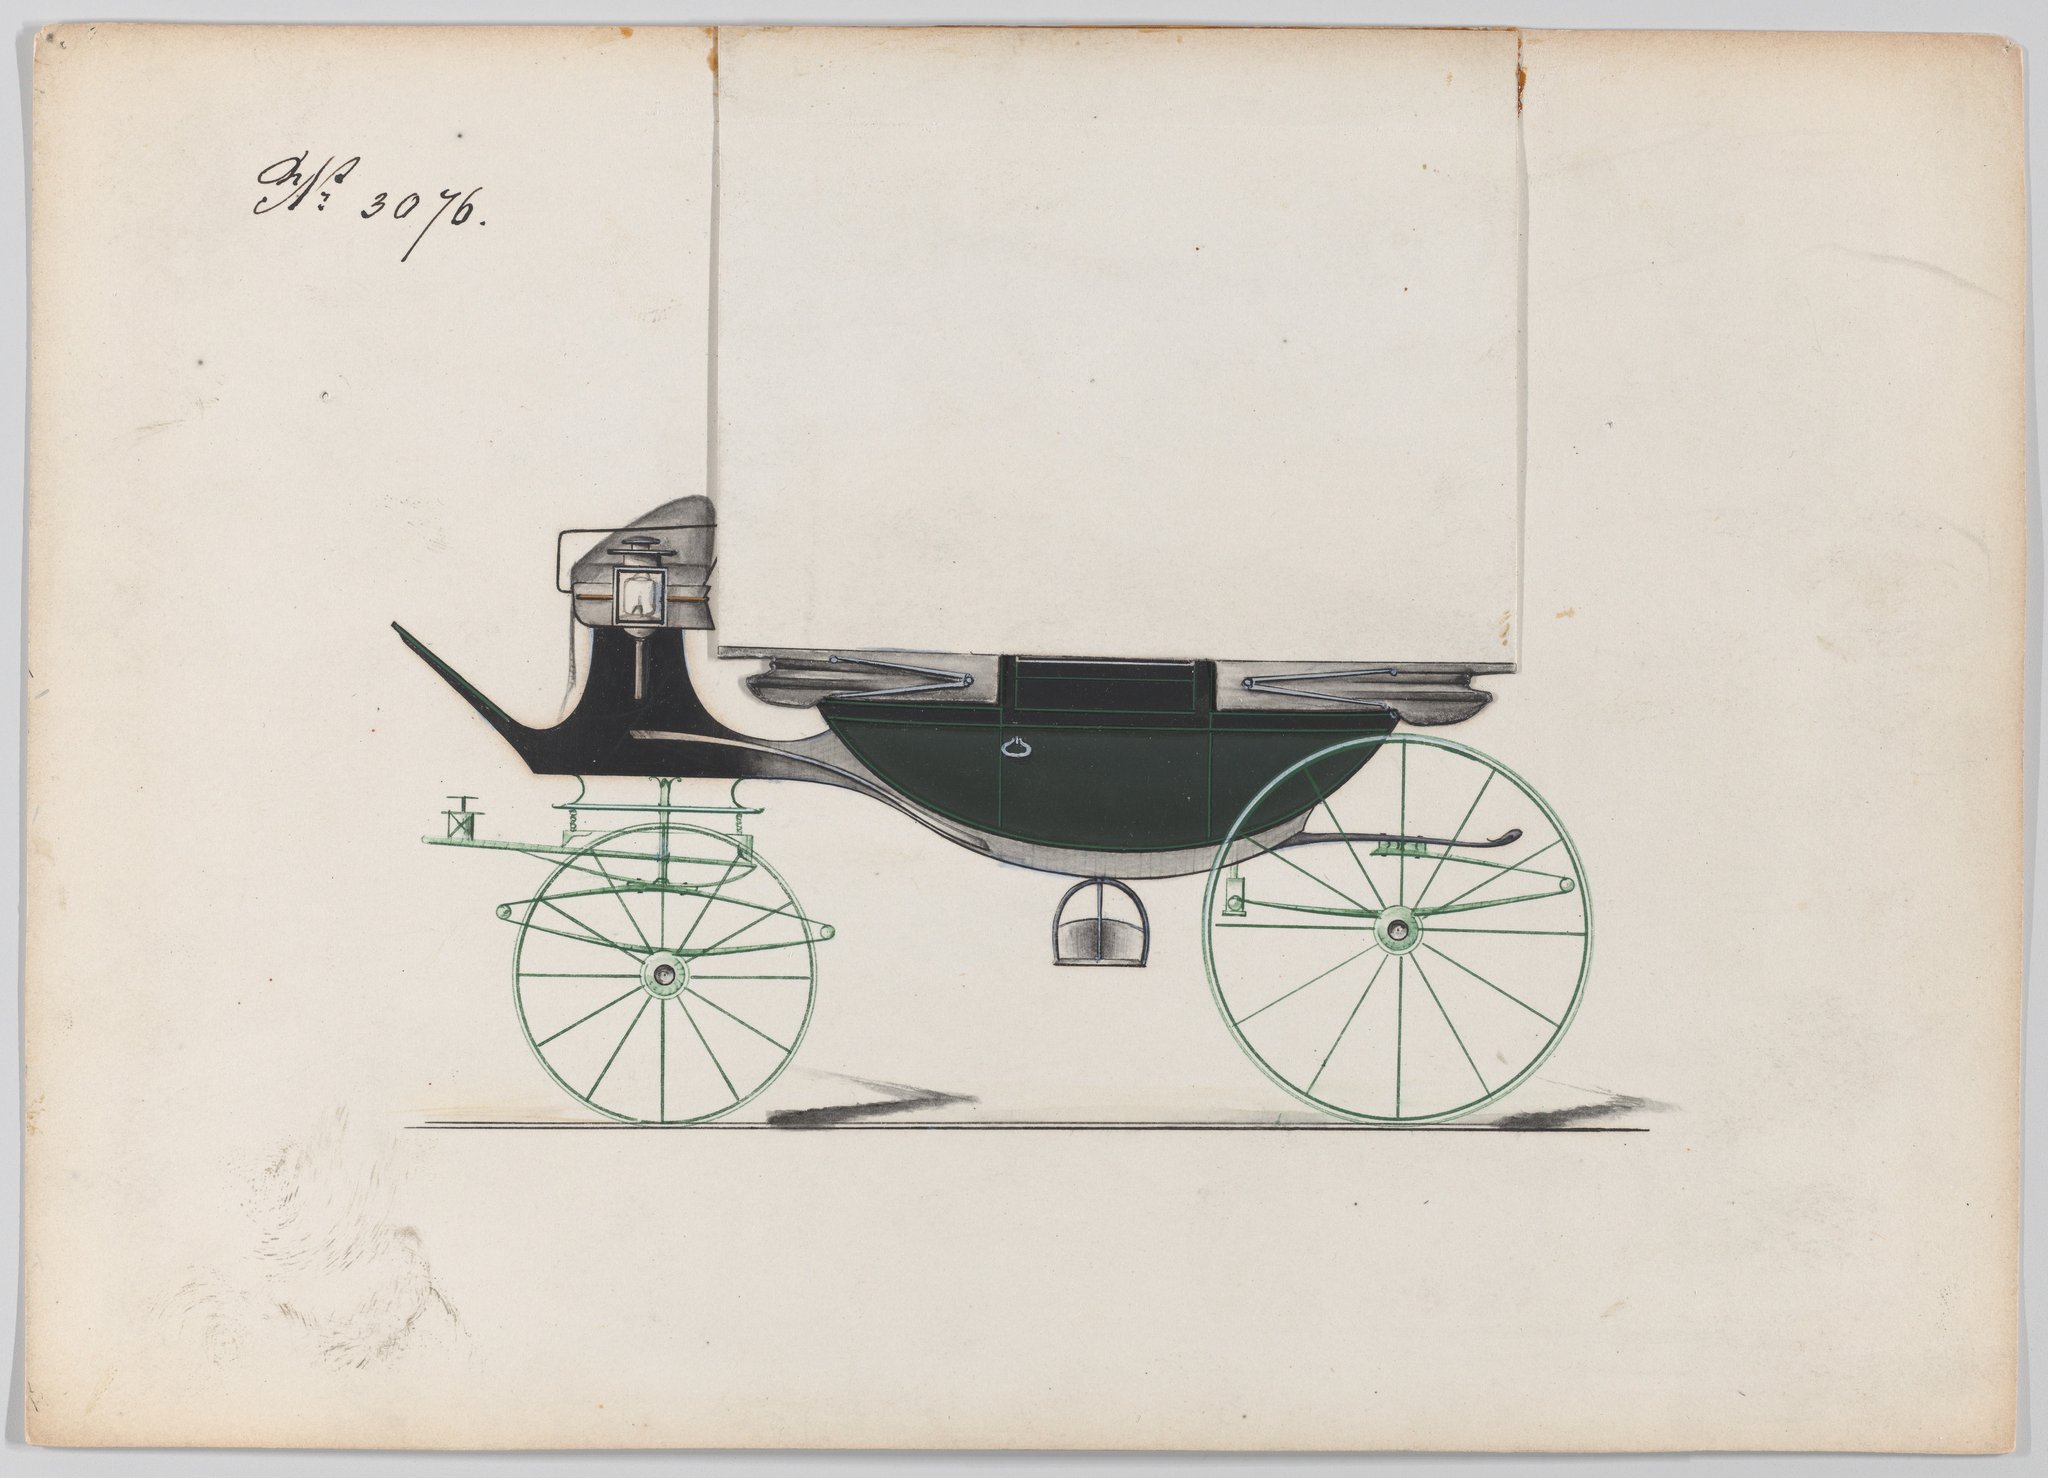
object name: drawing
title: Design for Landau, No. 3076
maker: brewster & co.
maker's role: manufacturer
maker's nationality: american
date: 1874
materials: gouache, gum arabic, ink, watercolor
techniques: pen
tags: carriages